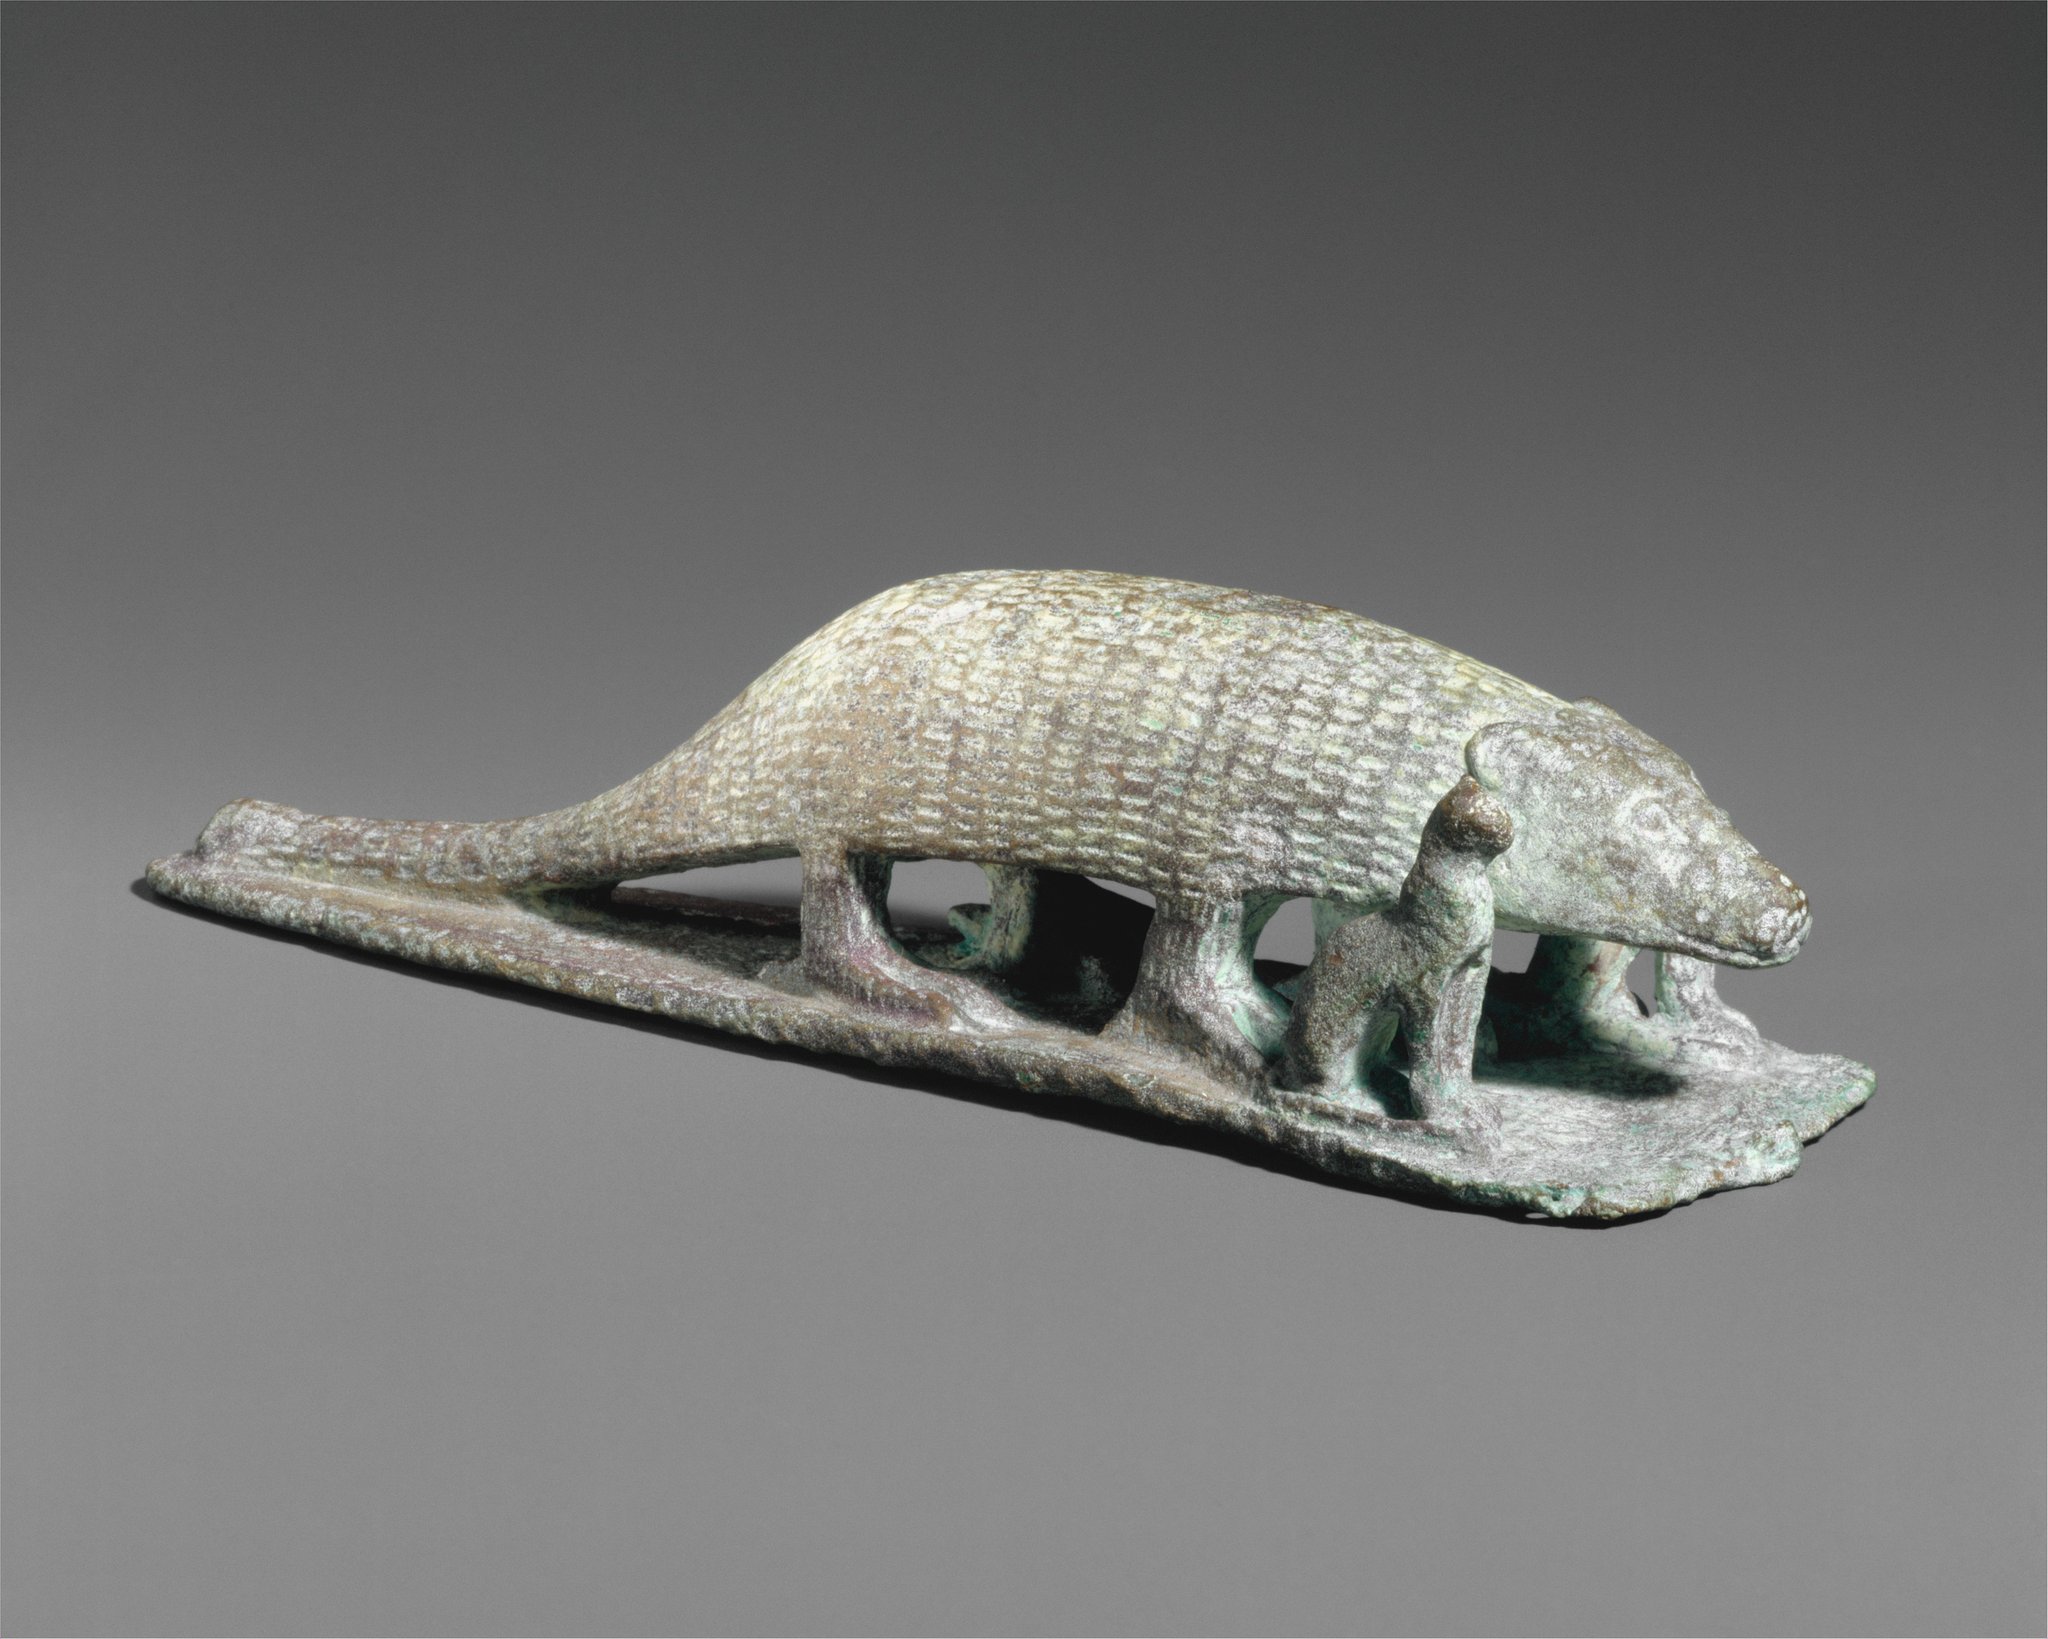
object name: amulet, ichneumon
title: Ichneumon on a base with small cats, inscribed beneath base with the name of Padineith son of Isekhebi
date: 664-630 BCE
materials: metal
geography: egypt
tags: animals